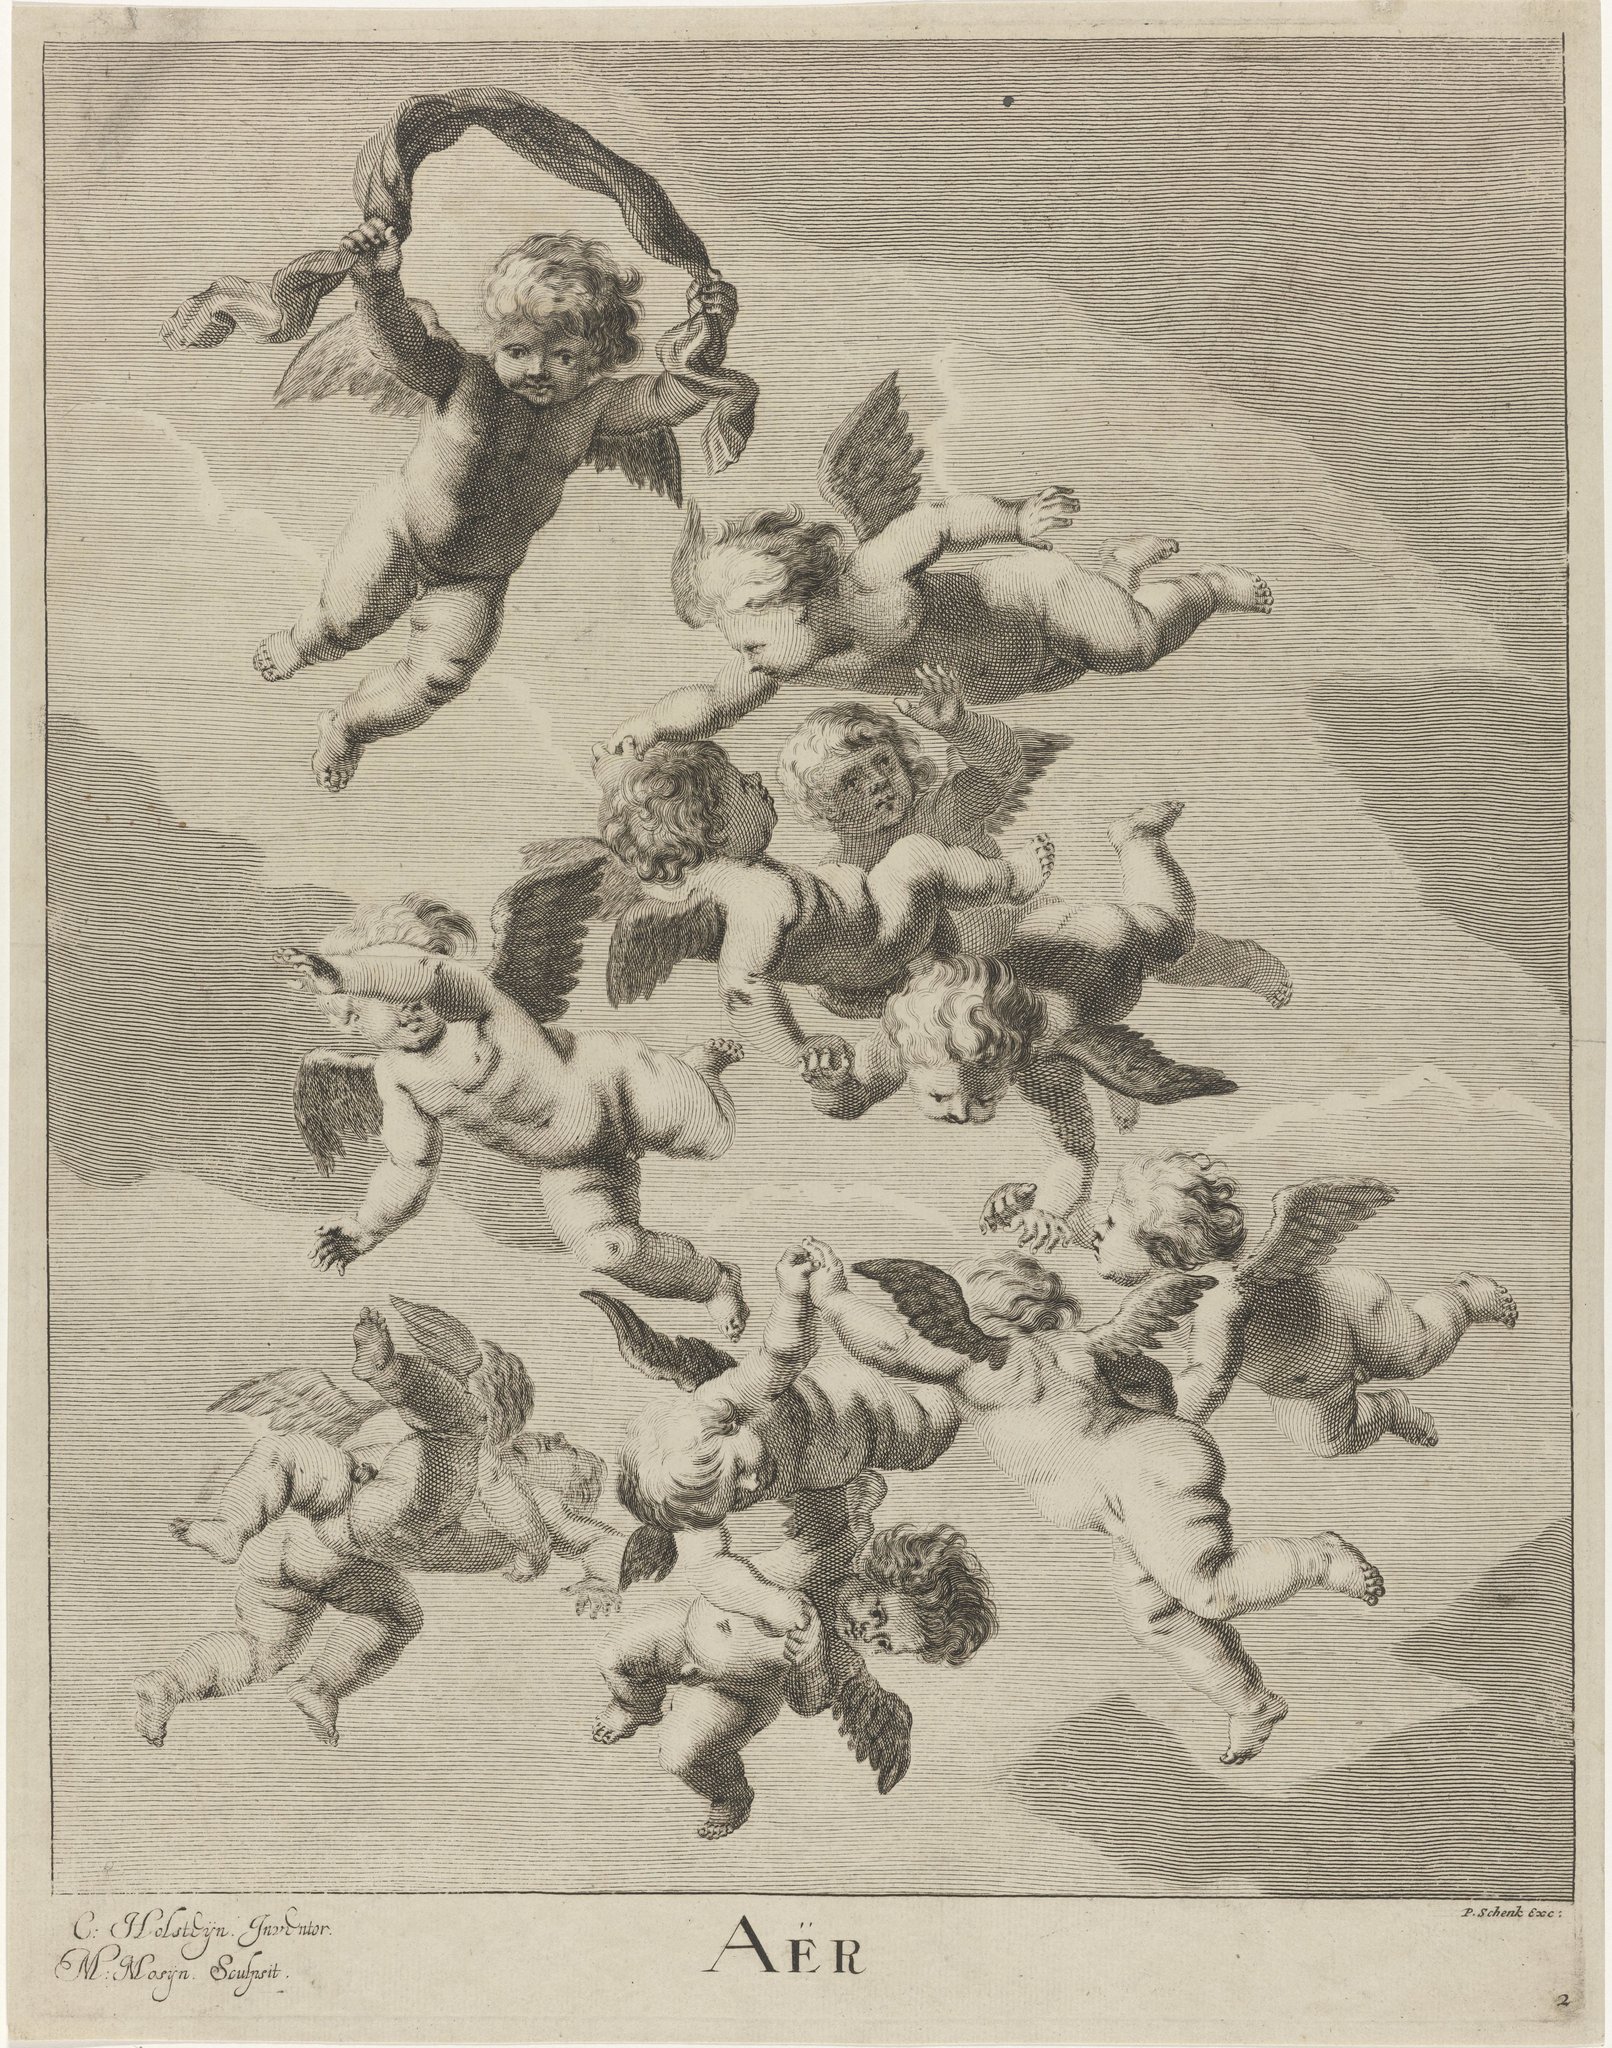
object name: print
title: De vier elementen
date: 1640-1655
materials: paper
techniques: engraving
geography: amsterdam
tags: air (one of the four elements), cupids: 'amores', 'amoretti', 'putti'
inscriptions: collector's mark: Lugt 2228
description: Vliegende putti in de lucht. Prent uit een serie van de vier elementen.